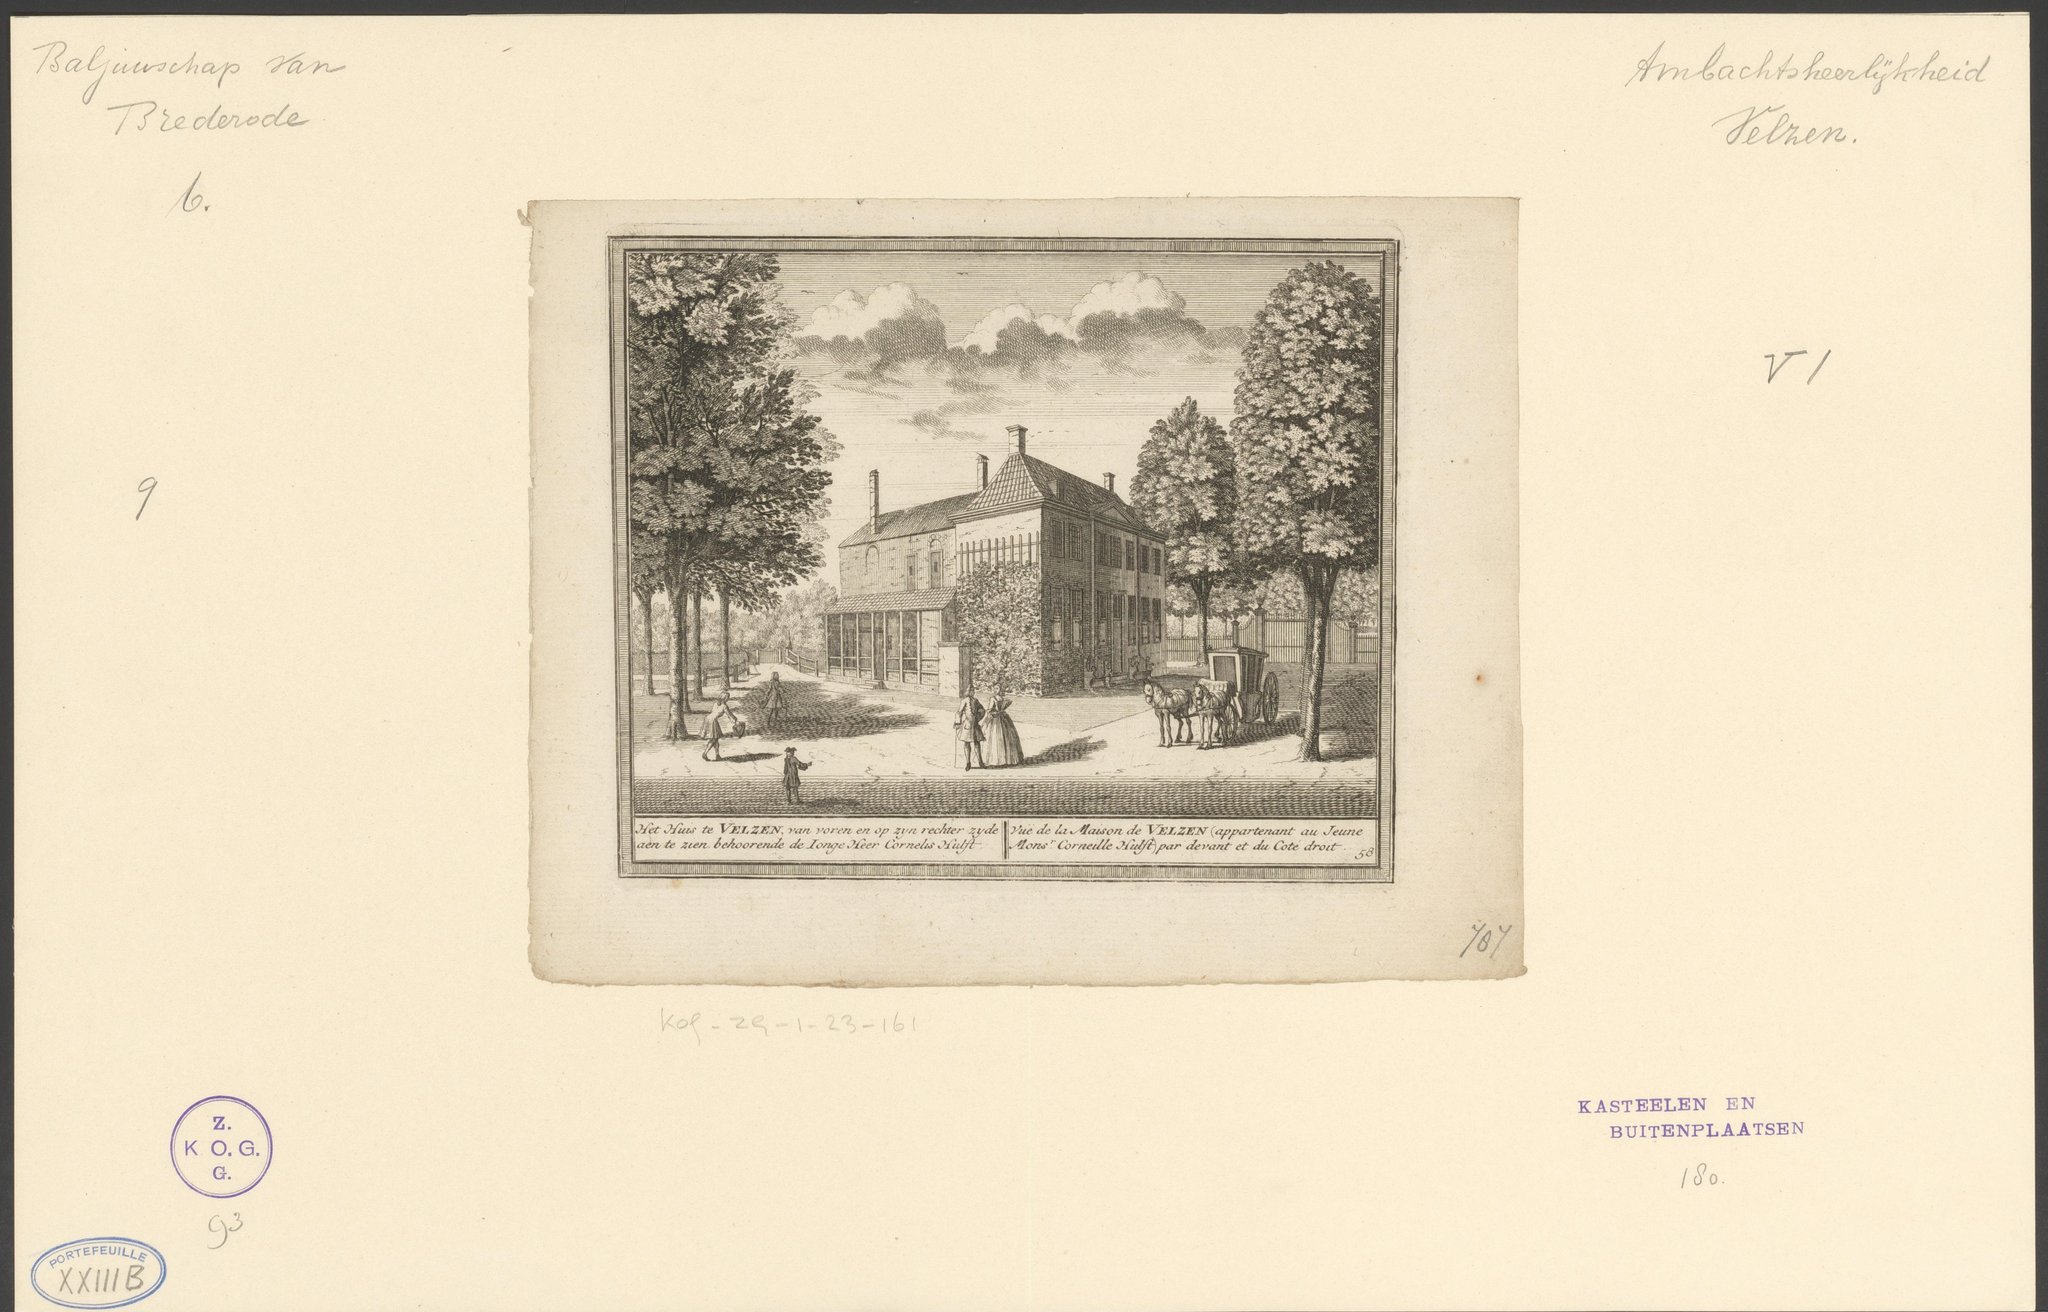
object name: print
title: Het Huis te Velzen, van voren en op zijn rechter zijde aen te zien behoorende de Jonge Heer Cornelis Hulst / Vuë de la Maison de Velzen (appartenant au Jeune Mons.r Corneille Hulst par devant et du Coté droit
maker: hendrik de leth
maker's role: draughtsman, print maker, publisher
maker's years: 1703-1766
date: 1732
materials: paper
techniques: engraving, etching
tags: two-wheeled vehicle drawn by one animal, country-house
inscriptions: stamp, stamp, collector's mark: Lugt 1641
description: Prent waarschijnlijk uit: Broüerius van Nidek, Mattheus. Het Zegenpralent Kennemerlant, vertoont in veele Heerlijke Gezichten. Amsterdam: Leth, Hendrik de en Leth, Andries de, 1732, dl. 2.